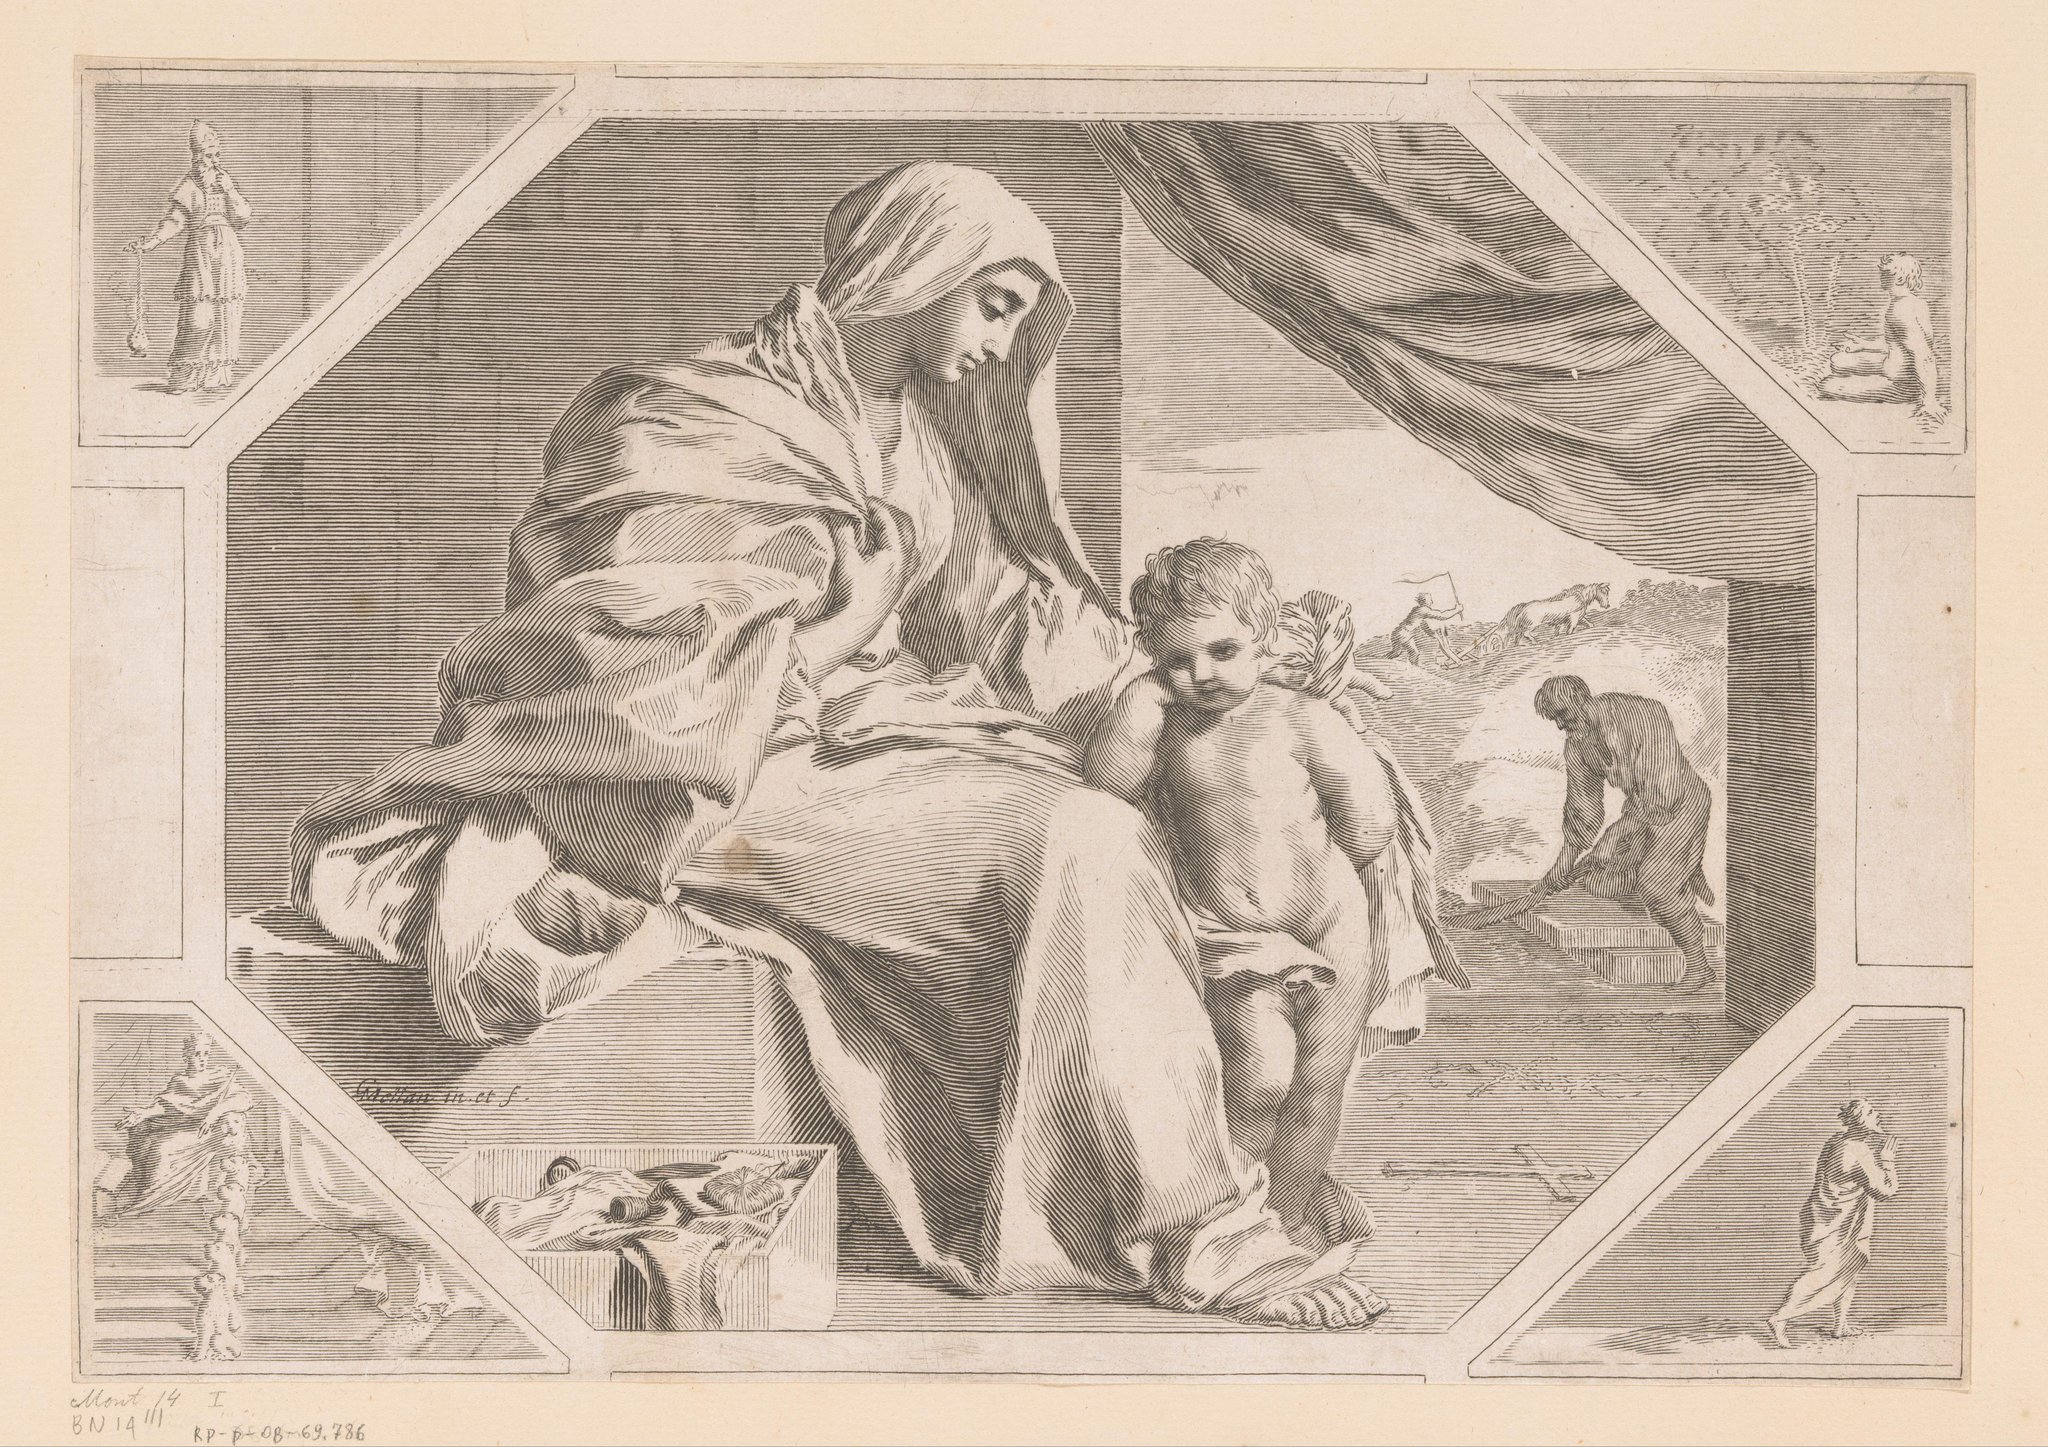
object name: print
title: Heilige Familie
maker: claude mellan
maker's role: draughtsman, print maker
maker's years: 1598-1688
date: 1650-1688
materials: paper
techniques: engraving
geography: france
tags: holy family, and derived representations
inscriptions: collector's mark: Lugt 240